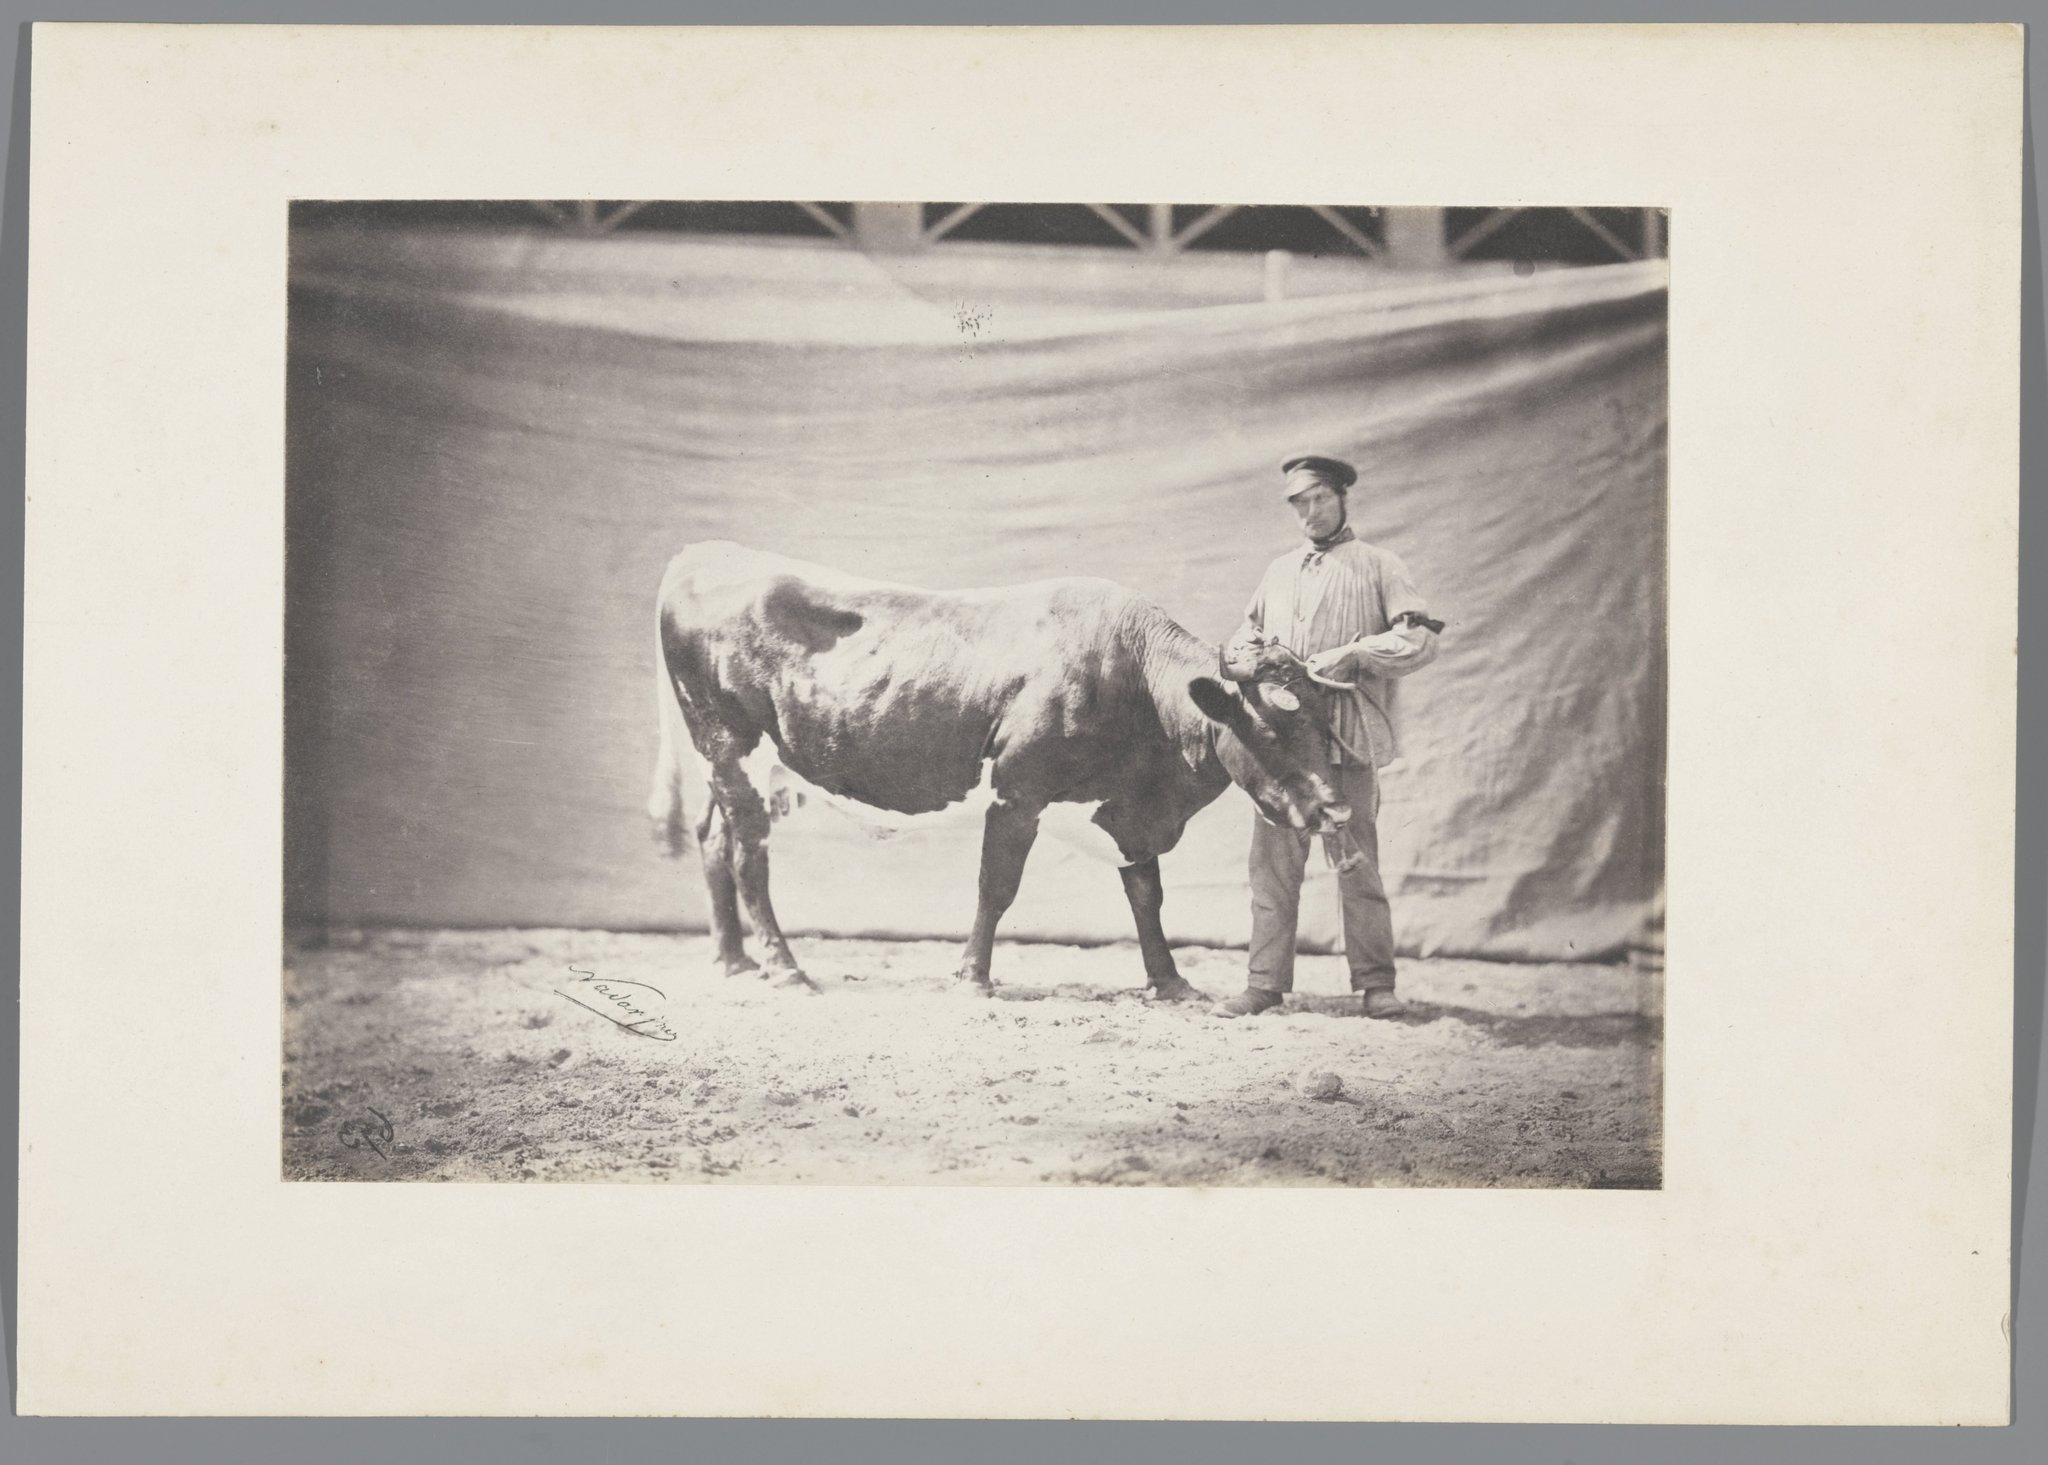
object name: photograph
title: Studie van een rund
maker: adrien tournachon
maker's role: fotograaf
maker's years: 1825-1903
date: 1856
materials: cardboard, paper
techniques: salted paper print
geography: paris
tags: bovine cattle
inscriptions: signature: ‘Nadar jeune’, number: ‘673’